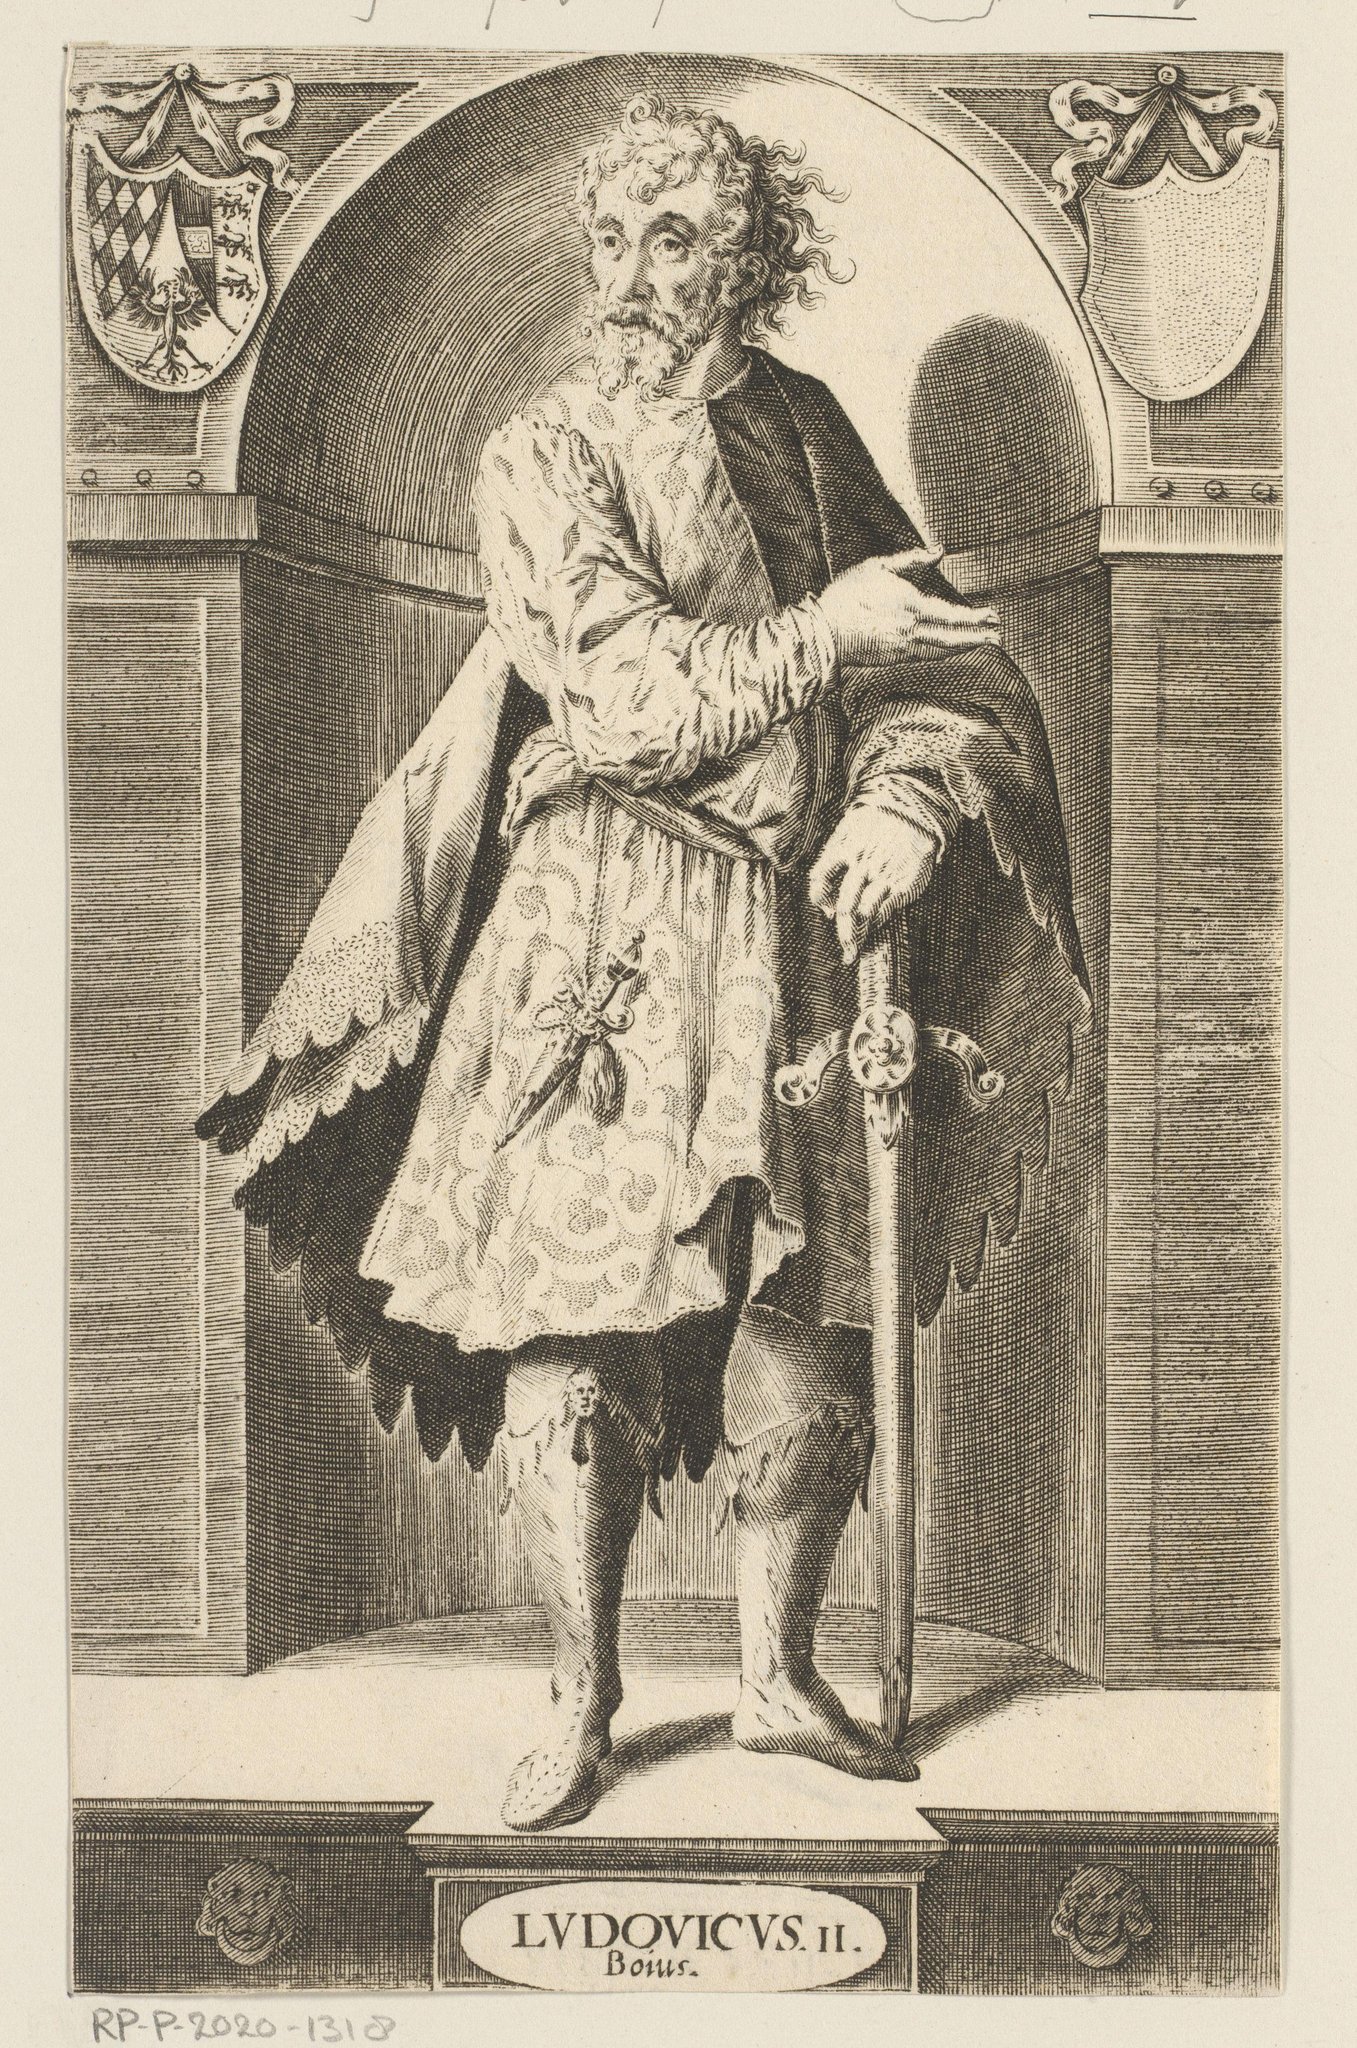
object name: print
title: Portret van Lodewijk II van Beieren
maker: dominicus custos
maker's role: print maker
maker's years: 1560-1615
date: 1599-1623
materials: paper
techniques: engraving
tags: historical persons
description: Prent ook gebruikt in: Henning, Marcus. Tirolensium Principum Comitum. Augsburg: Johannes Praetorius, 1599. Prent ook gebruikt in latere edities, in ieder geval tot 1623.